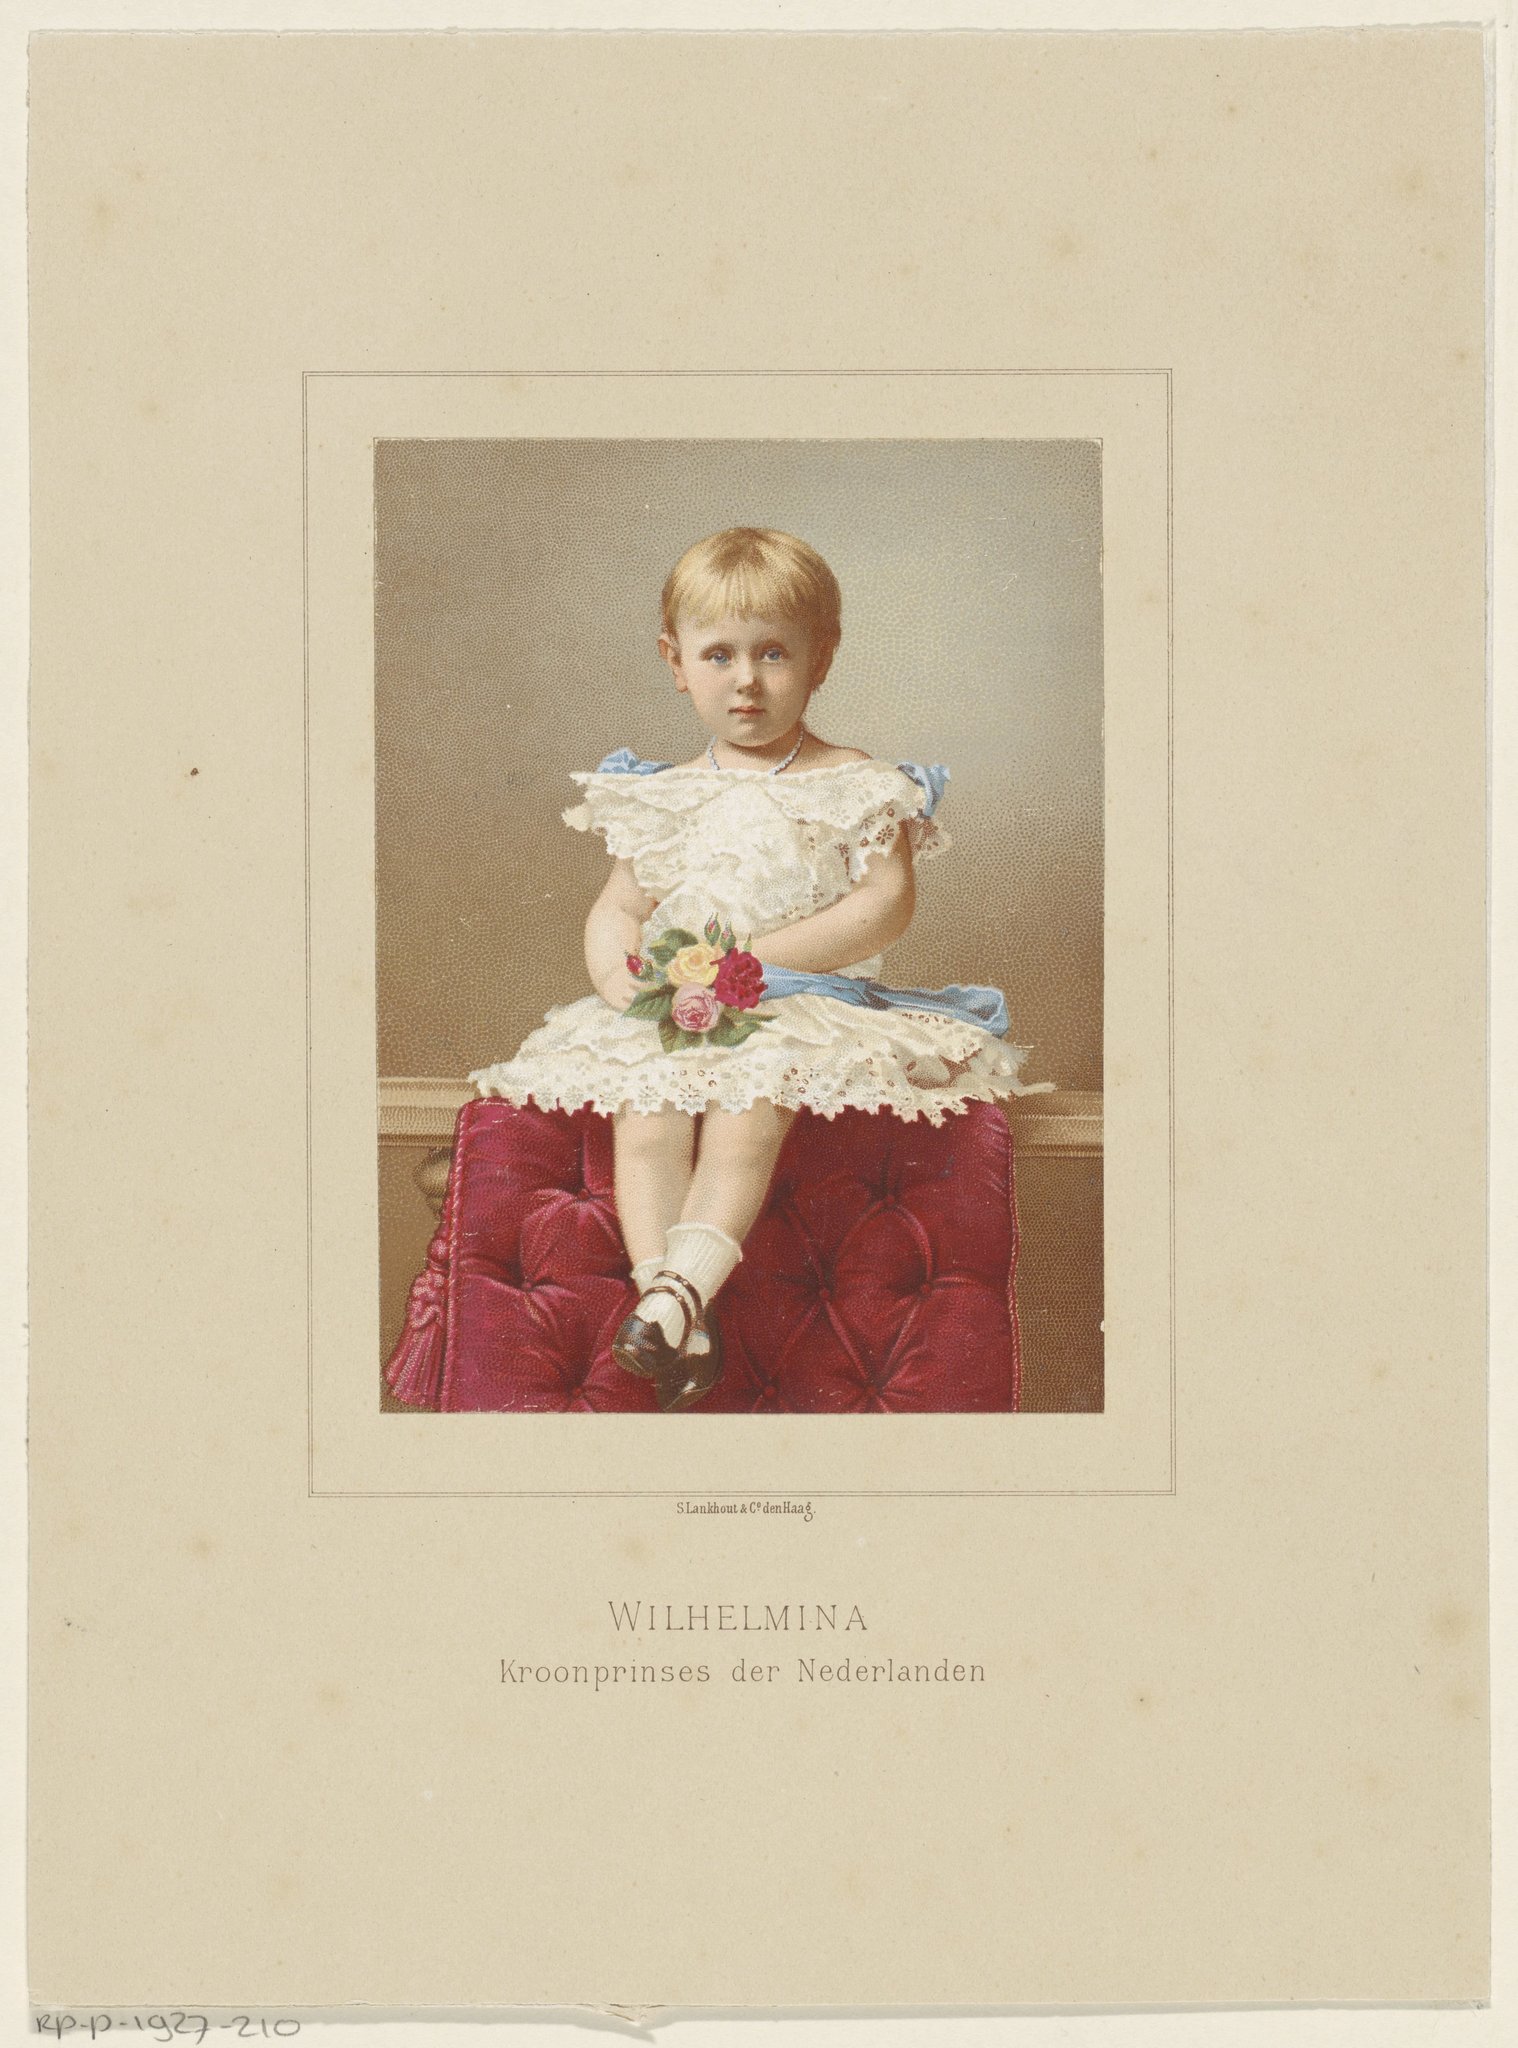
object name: print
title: Portret van Wilhelmina, koningin der Nederlanden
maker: Anonymous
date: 1882-1903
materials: paper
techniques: lithograph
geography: the hague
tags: the hague, print maker, wilhelmina of the netherlands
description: De hier vermelde titel verwijst naar de hoogst verkregen titel van de geportretteerde, niet per se naar de titel die de geportretteerde op deze voorstelling draagt.